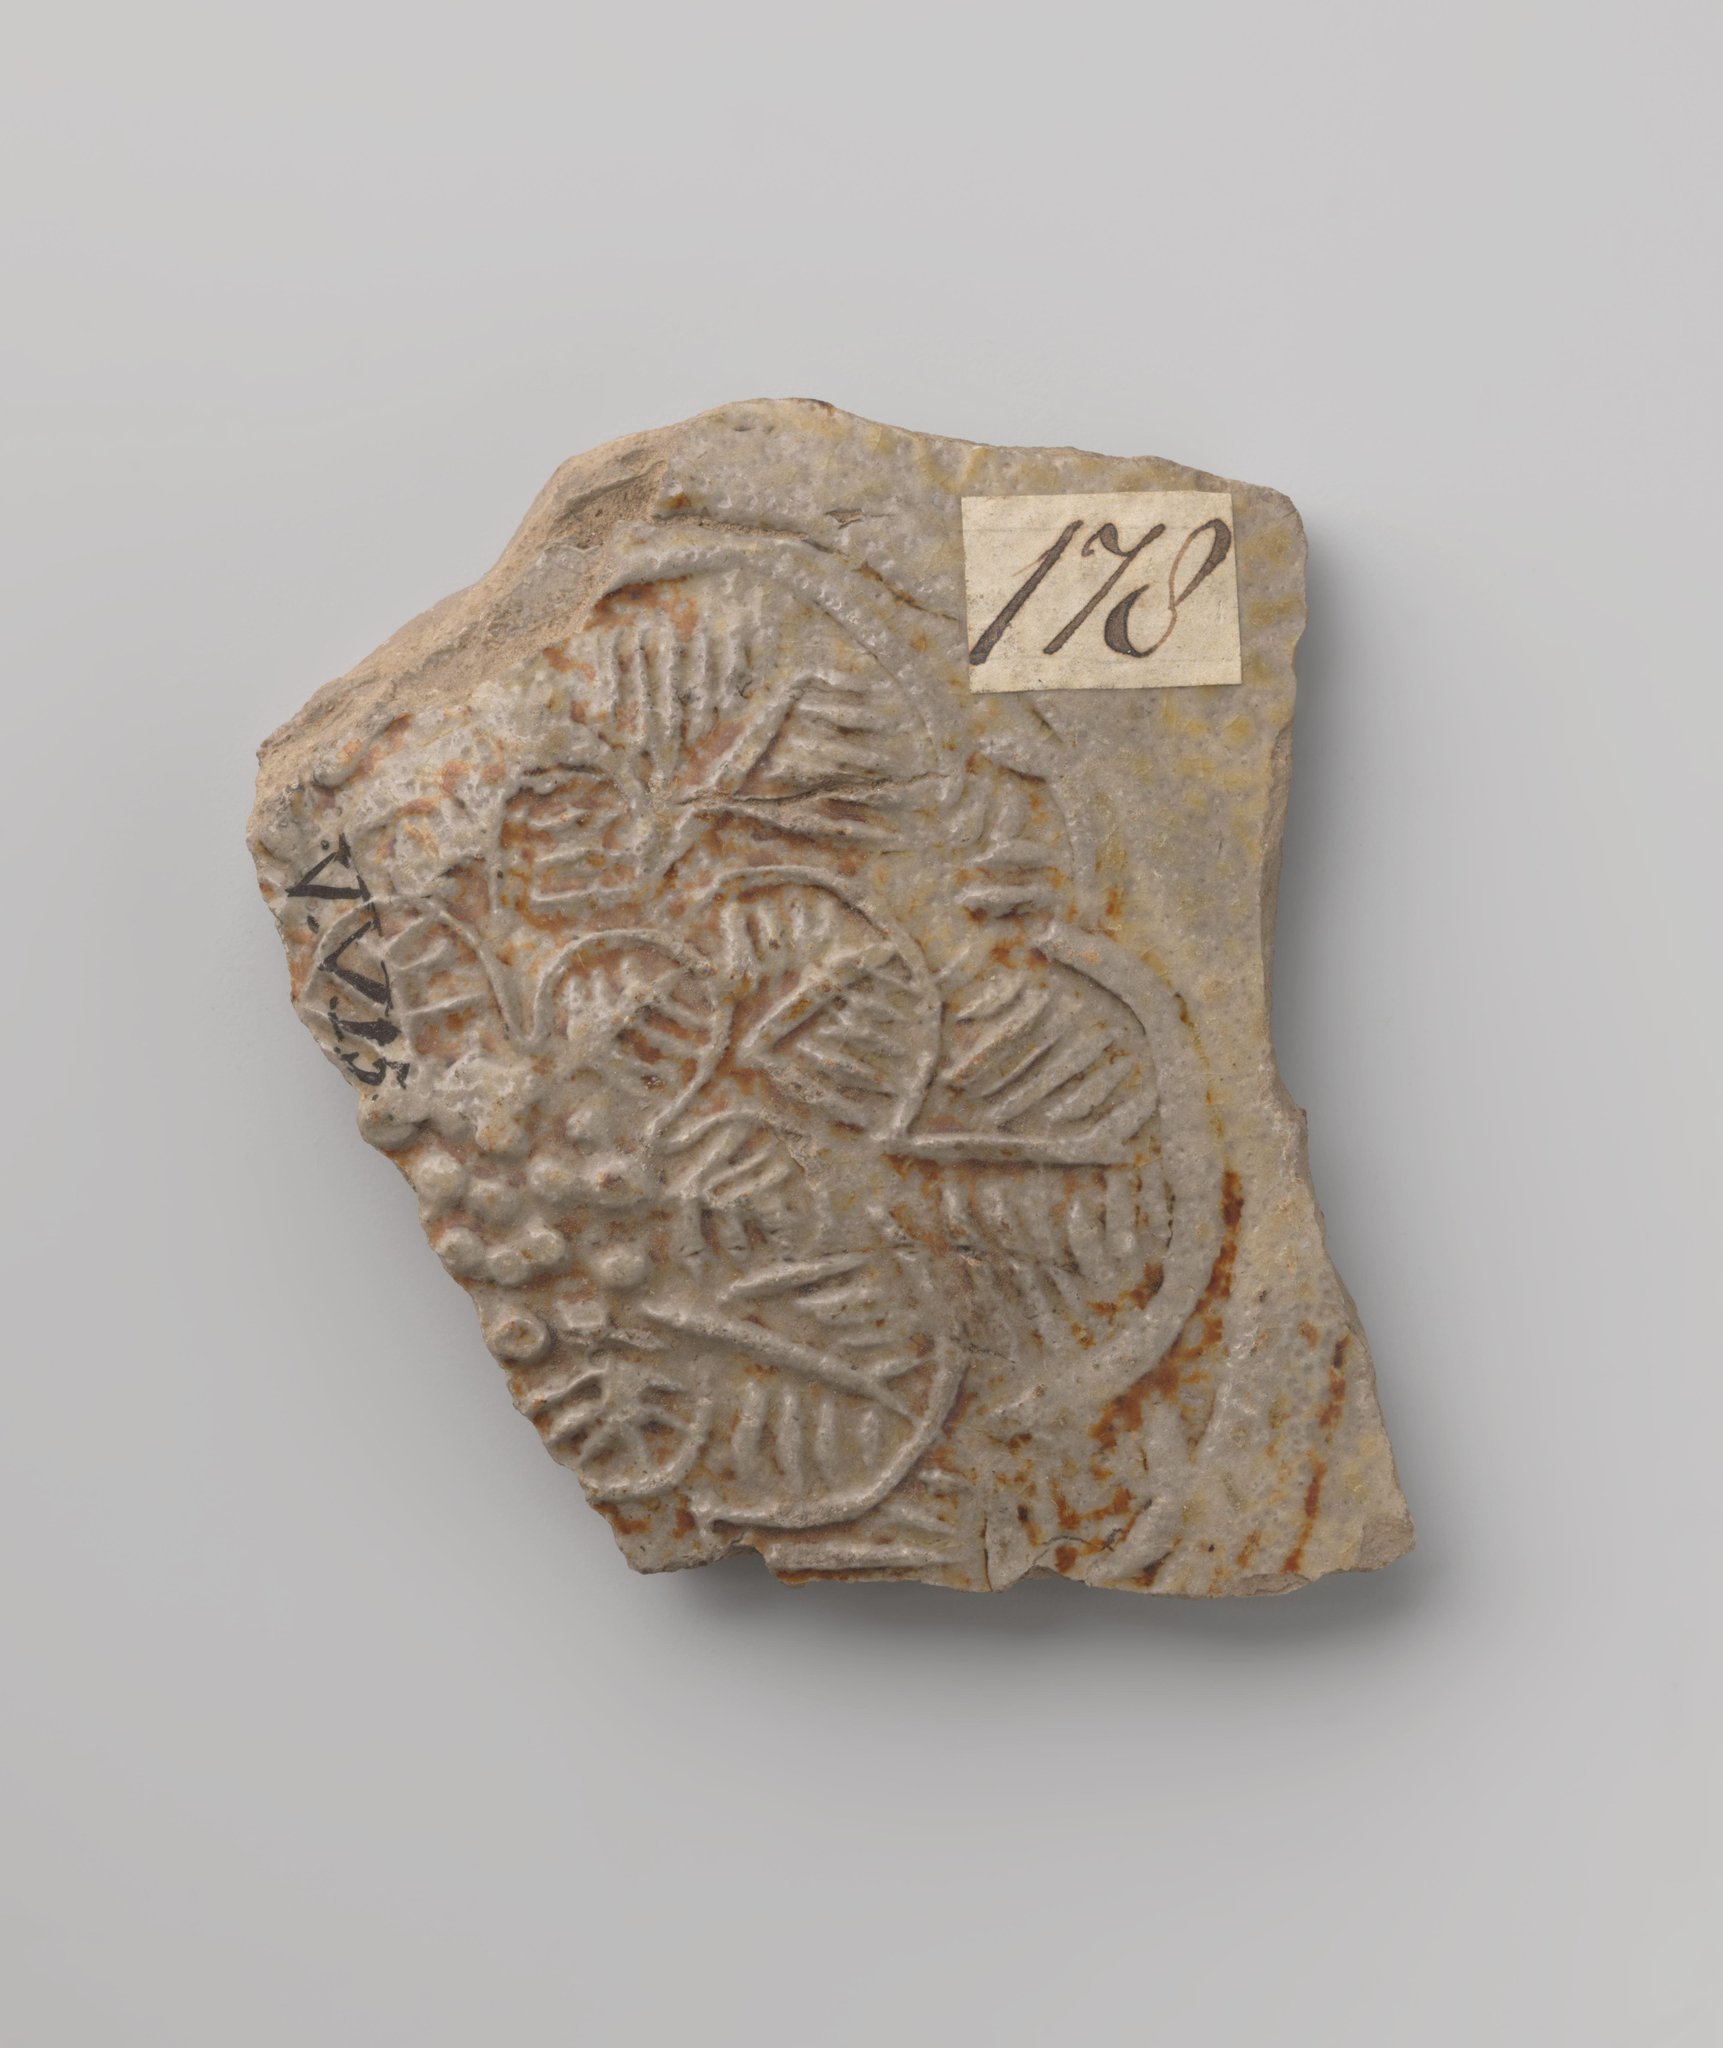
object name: fragment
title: Fragment of a jug with a flower roundel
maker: Anonymous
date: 1570-1610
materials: glaze, stoneware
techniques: firing, forming, relief, turning, vitrification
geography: raeren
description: Fragment van een kruik van steengoed. Op de scherf in reliëf een deel van een bloemrozet in een medaillon. Raeren of Frechen.